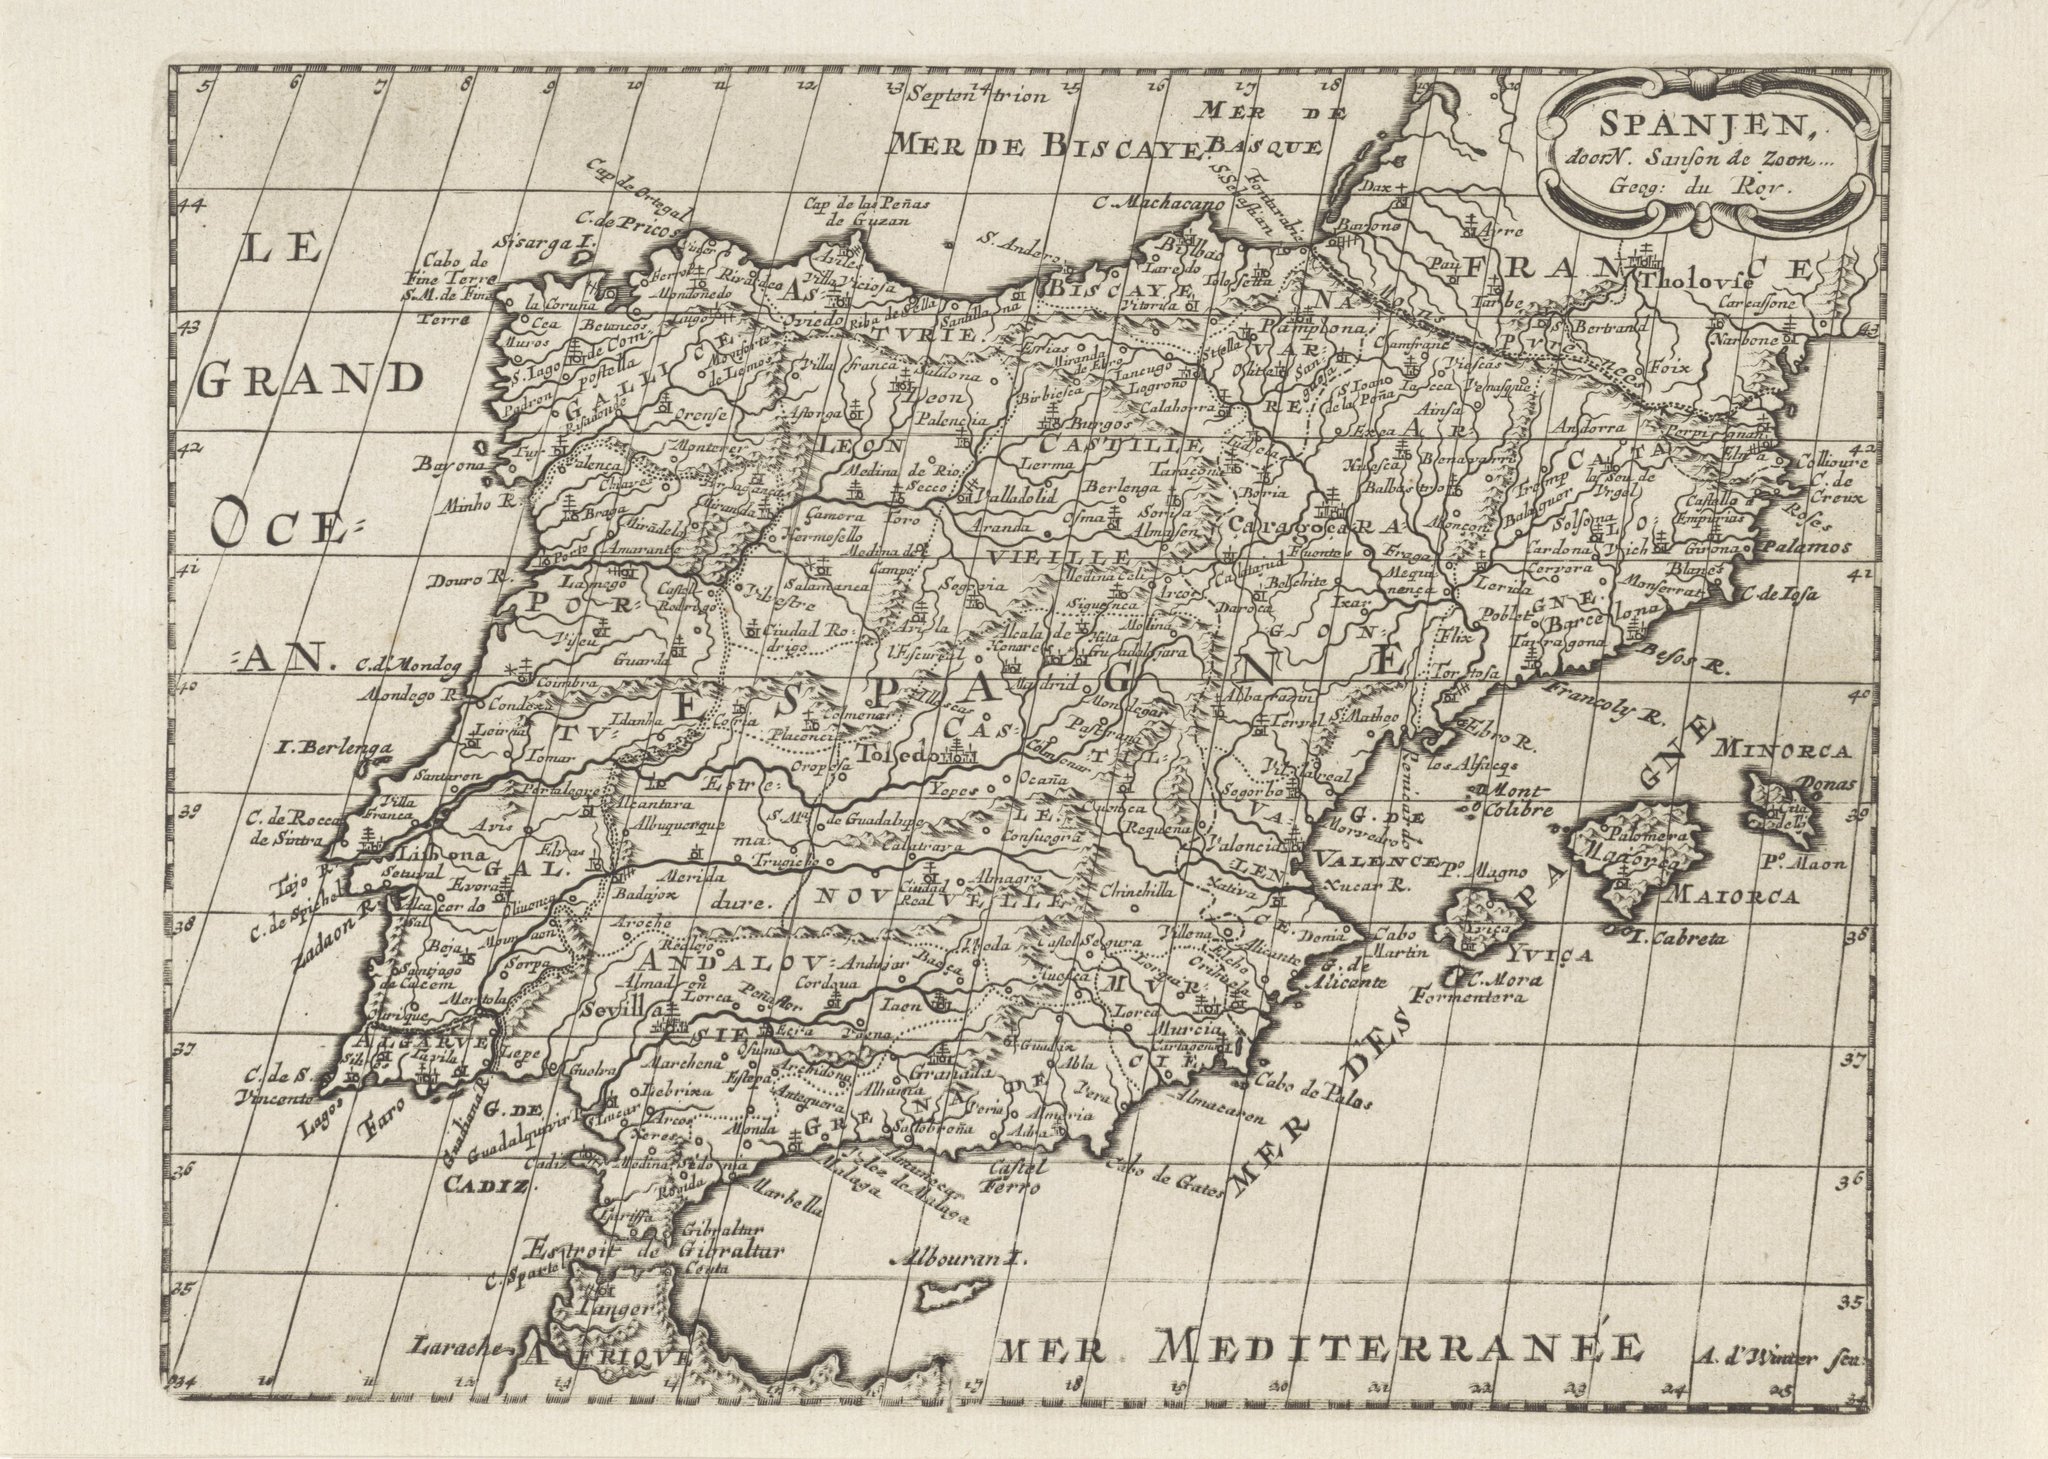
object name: print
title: Kaart van Spanje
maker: anthonie de winter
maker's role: print maker, publisher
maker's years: 1652-1707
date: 1683-1735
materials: paper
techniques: etching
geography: northern netherlands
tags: maps, atlases, spain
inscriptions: collector's mark: Lugt 2760, collector's mark: Lugt 2228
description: Prent is als boekillustratie onder andere gebruikt in: Croix, A. Phérotée de la. Algemeene weereld-beschryving, nae de rechte verdeeling der landschappen, plaetsen, zeeën, rivieren &c. Geographisch, politisch, historisch, chronologisch en genealogisch..., Amsterdam: François Halma, 1705